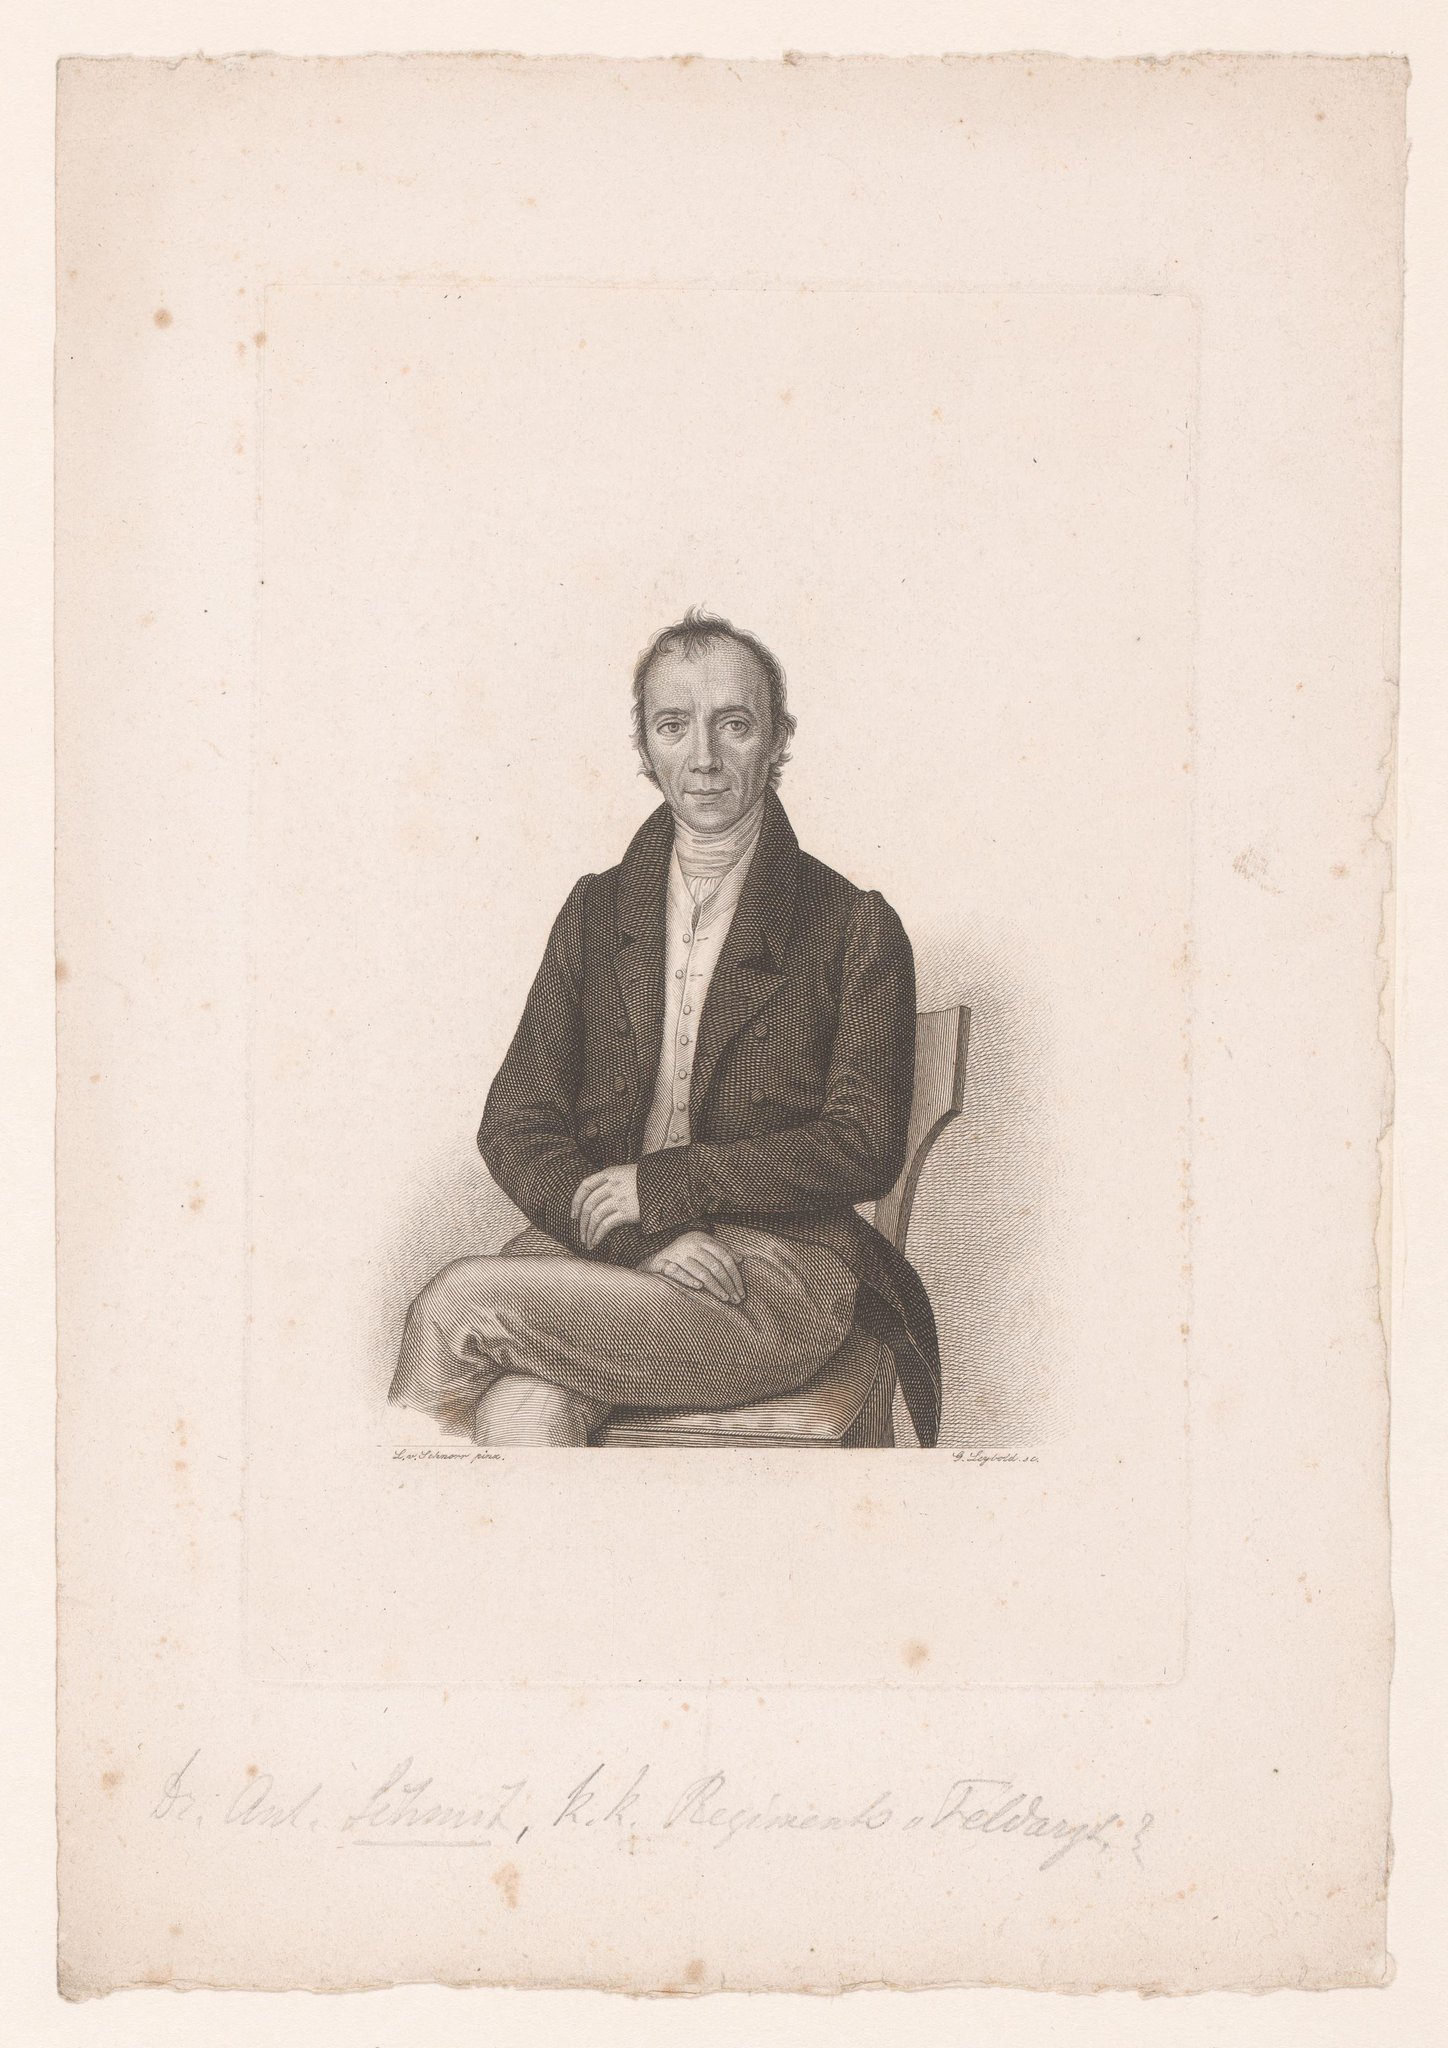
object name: print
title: Portret van Philipp Karl Hartmann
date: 1804-1842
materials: paper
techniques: engraving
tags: historical persons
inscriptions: collector's mark: Lugt 2228